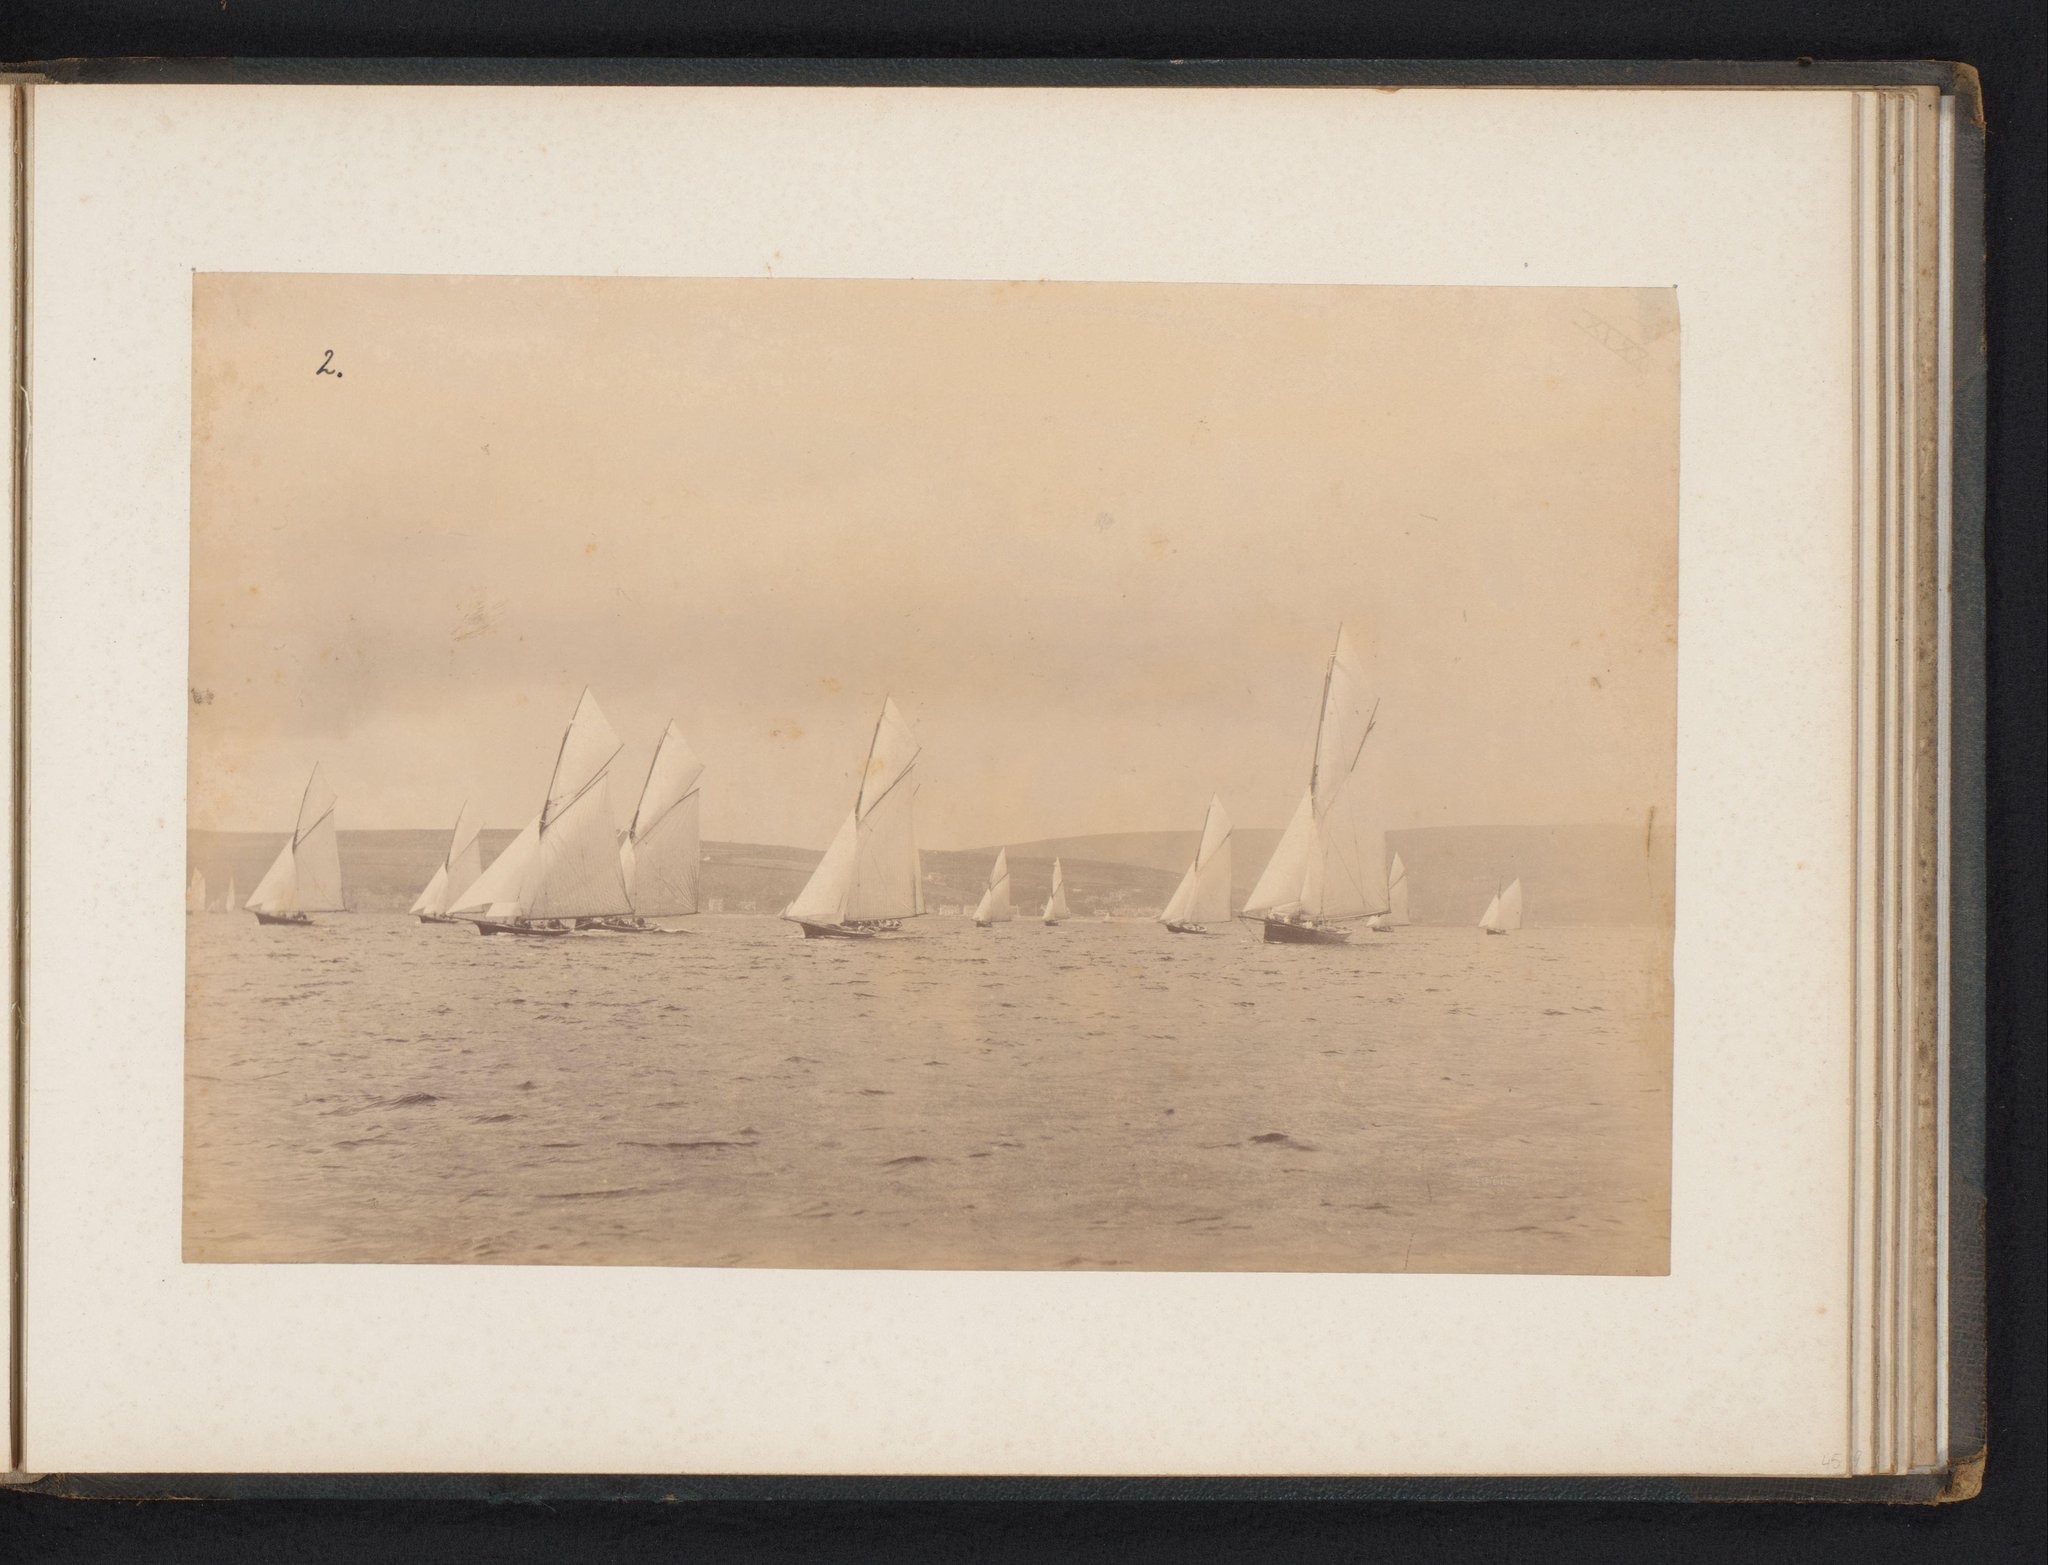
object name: album leaf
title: Zeilschepen tijdens de start van de Ardrishaig Cup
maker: james adamson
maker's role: fotograaf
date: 1880-1900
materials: photographic support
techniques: albumen print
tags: sailing-ship, sailing-boat, landscapes with waters, waterscapes, seascapes (in the temperate zone)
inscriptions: check stamp: ‘Adamson, Rothesay.H.B/ Copyright’, number: ‘2’